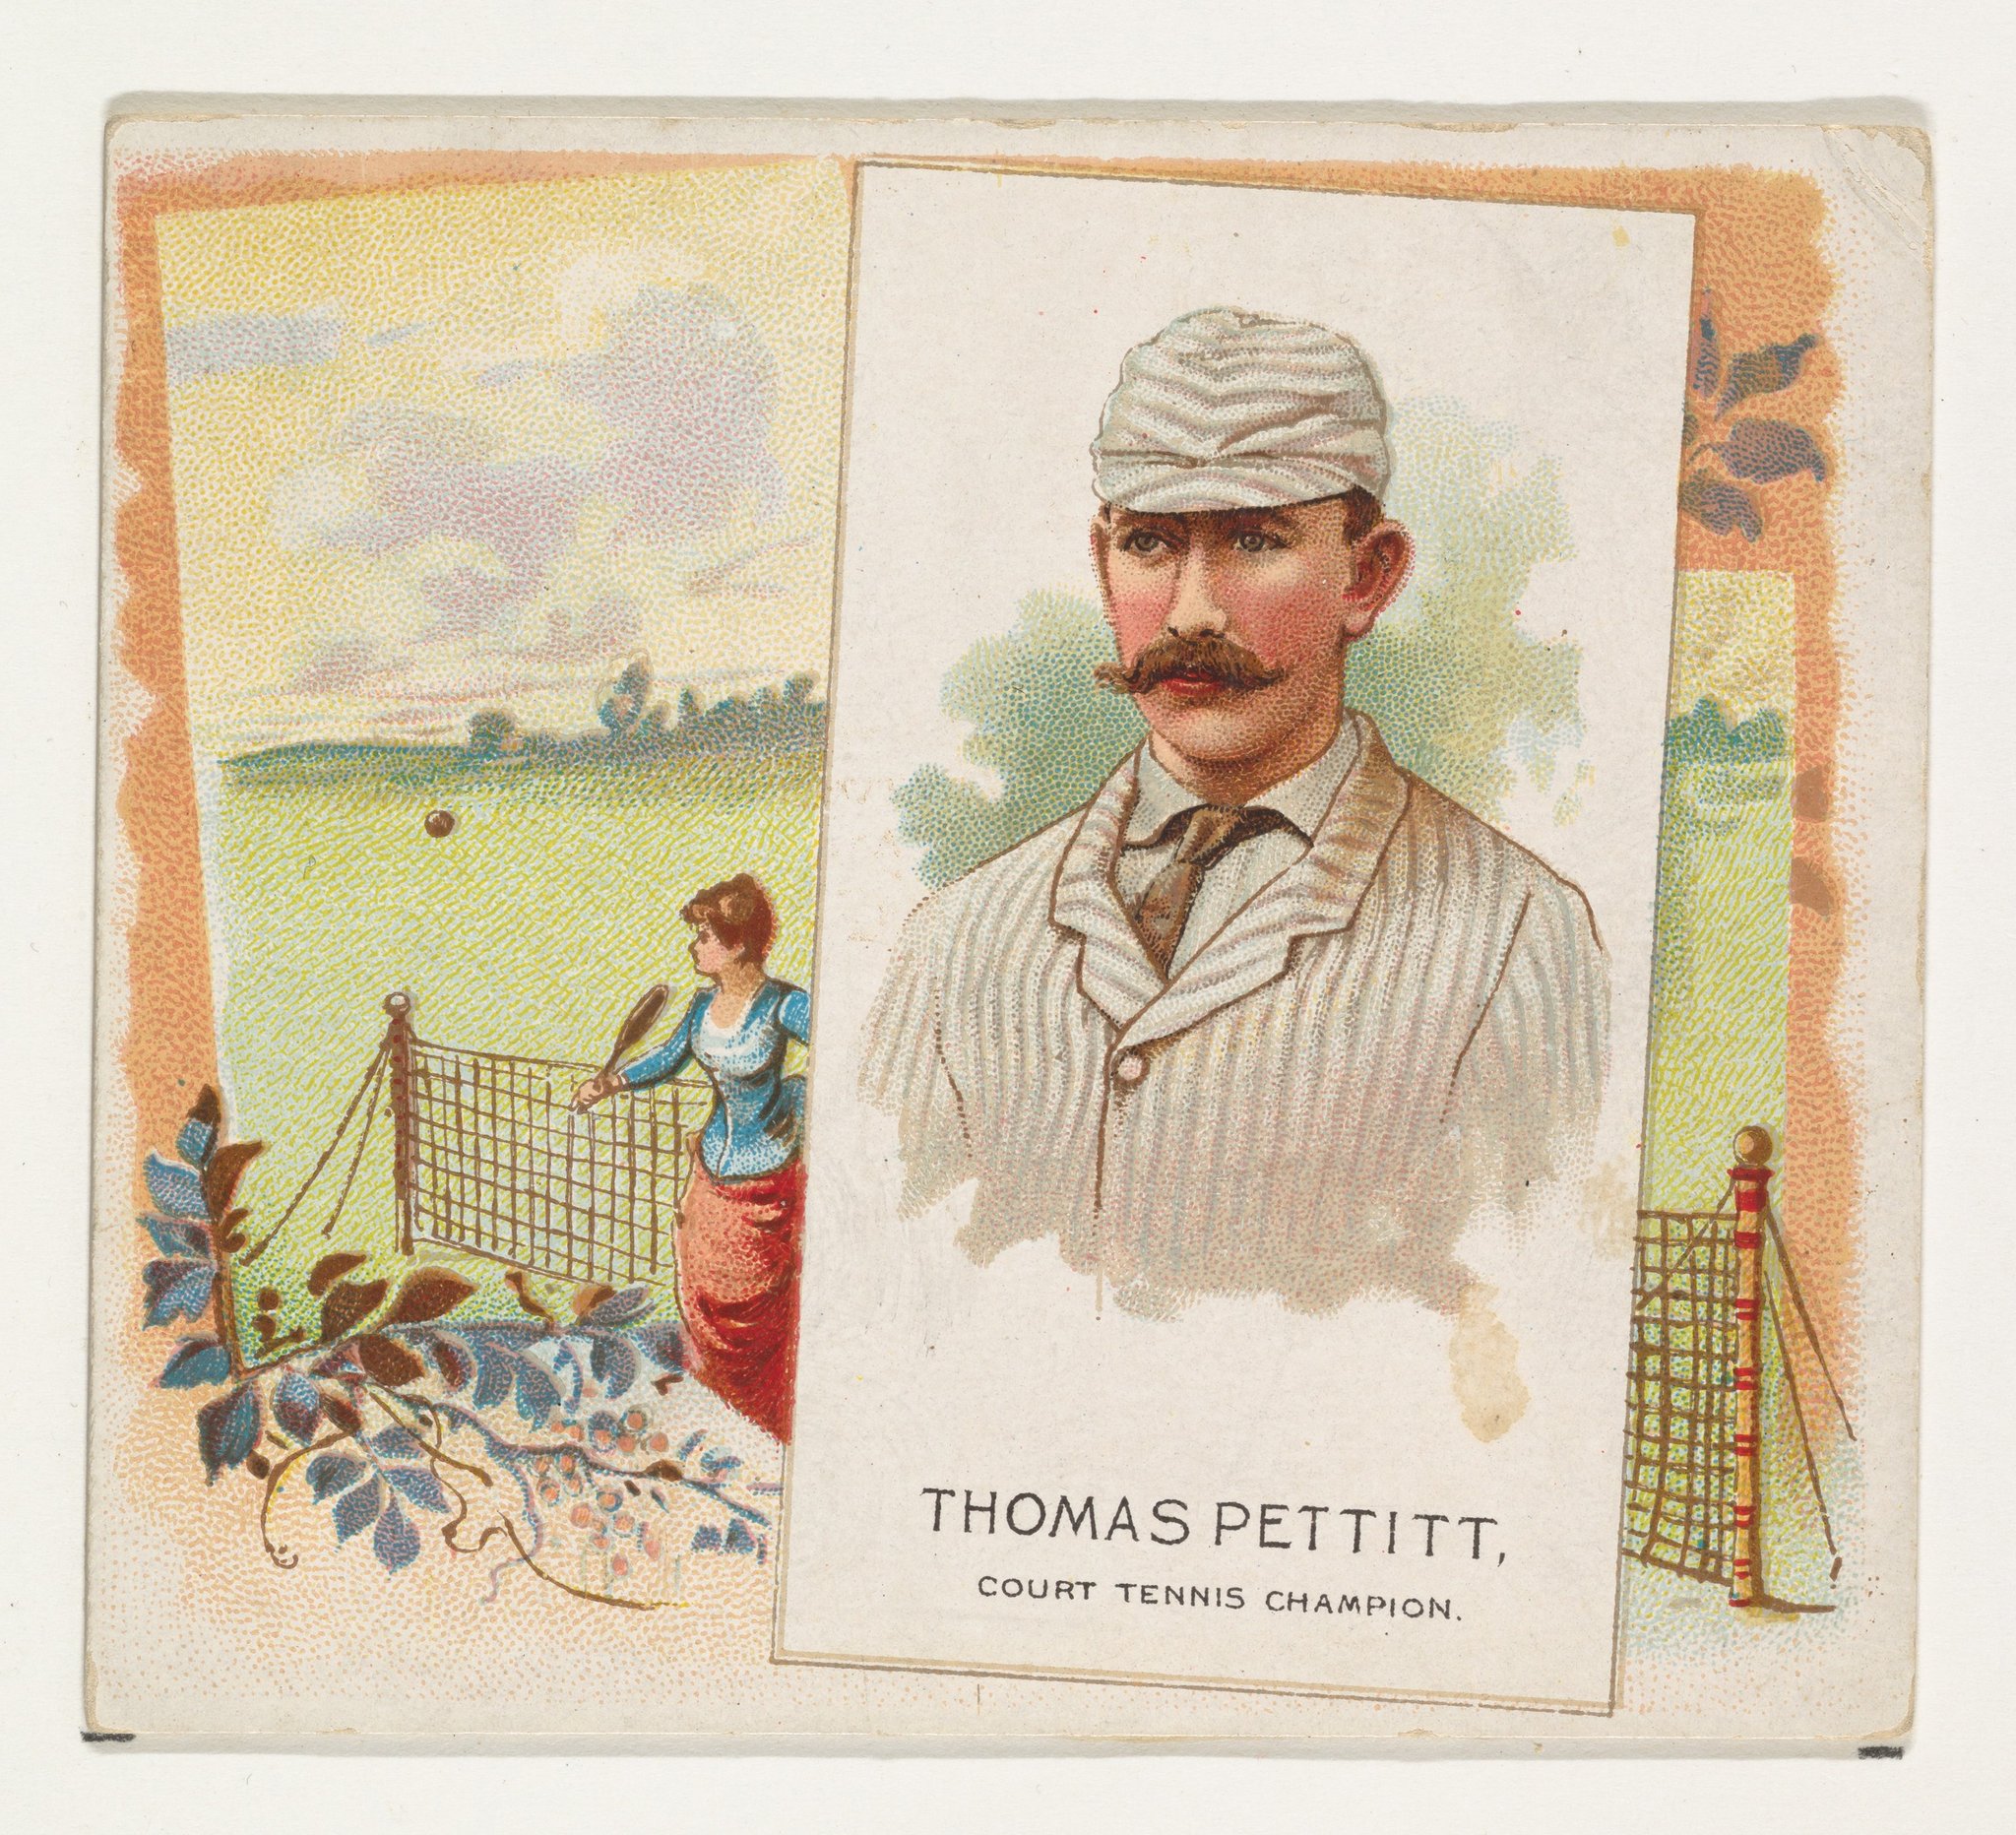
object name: print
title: Thomas Pettitt, Court Tennis Champion, from World's Champions, Second Series (N43) for Allen & Ginter Cigarettes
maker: allen & ginter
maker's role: publisher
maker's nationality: american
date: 1888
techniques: lithography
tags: men,portraits,women,tennis